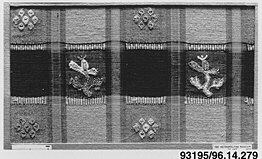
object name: piece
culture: japanese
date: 1701-1900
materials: silk